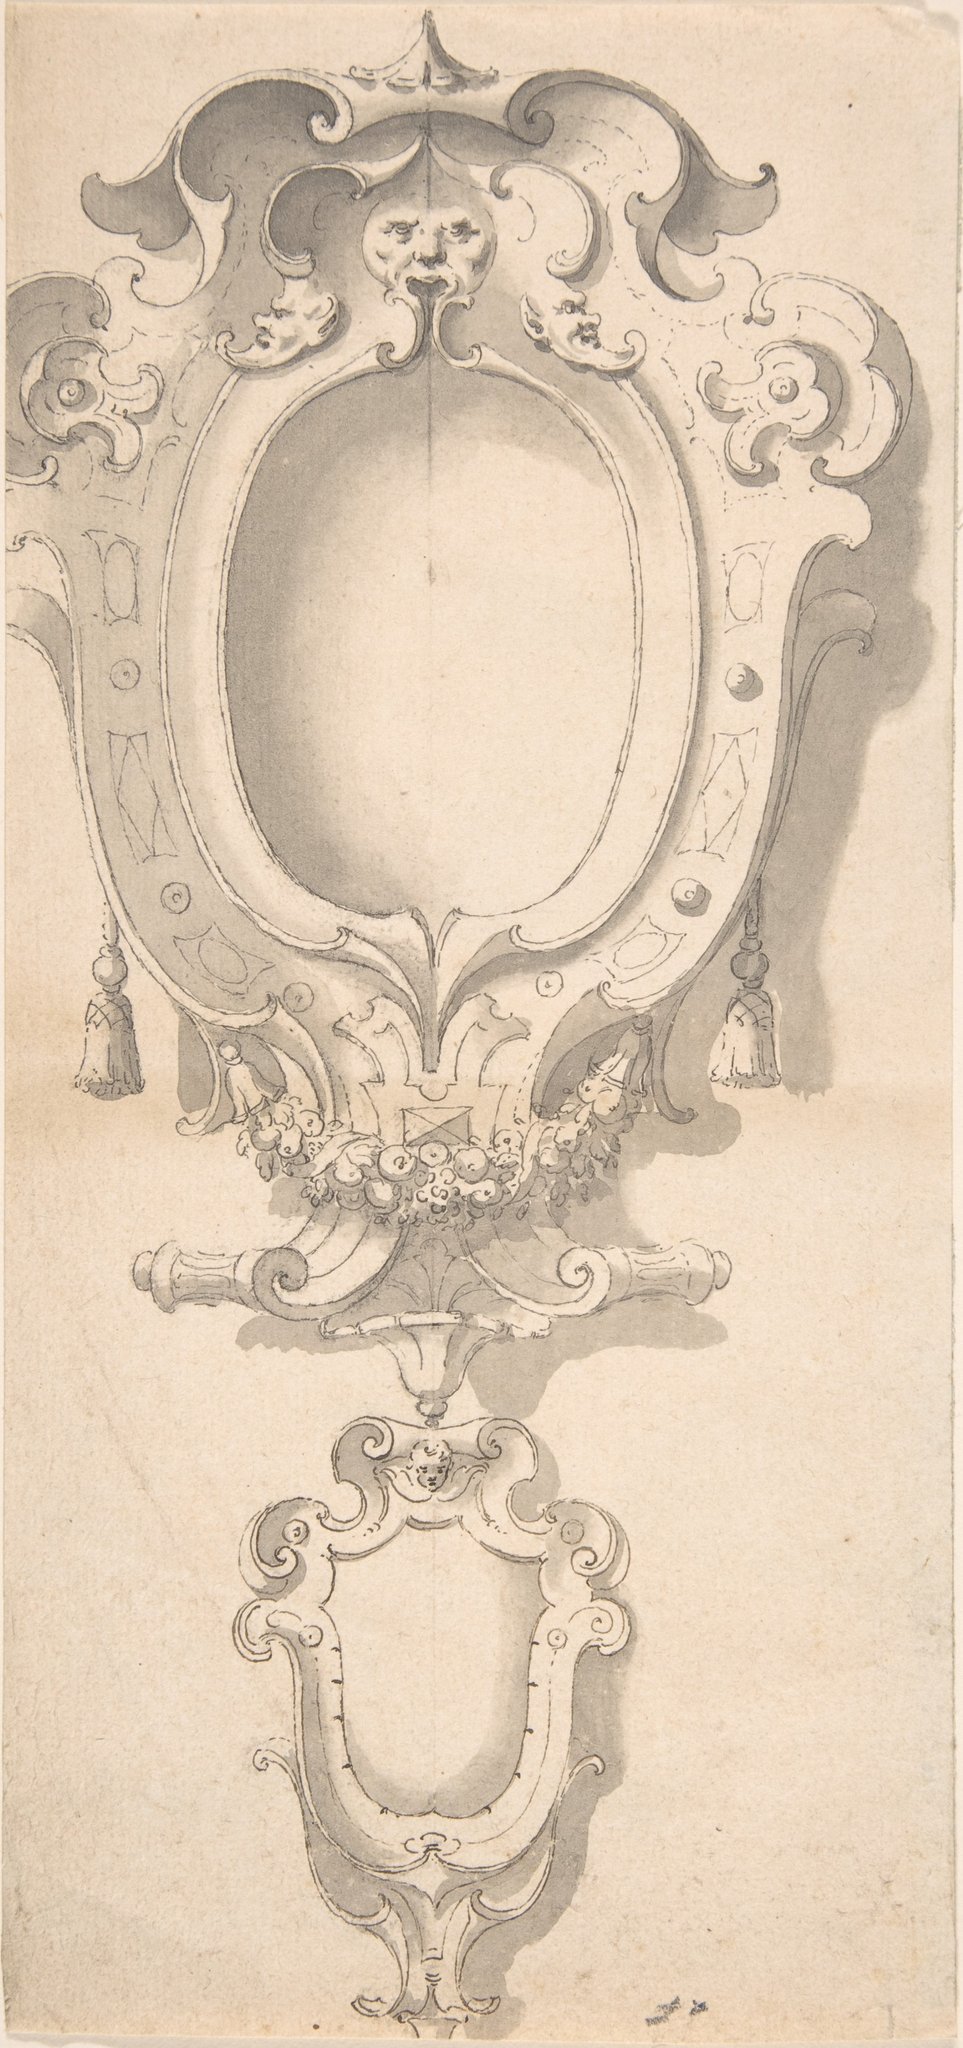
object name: drawing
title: Cartouche Designs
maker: anonymous, italian, 17th century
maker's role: artist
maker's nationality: italian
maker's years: 1600-1700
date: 1601-1700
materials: ink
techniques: brush, pen, wash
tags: cartouches